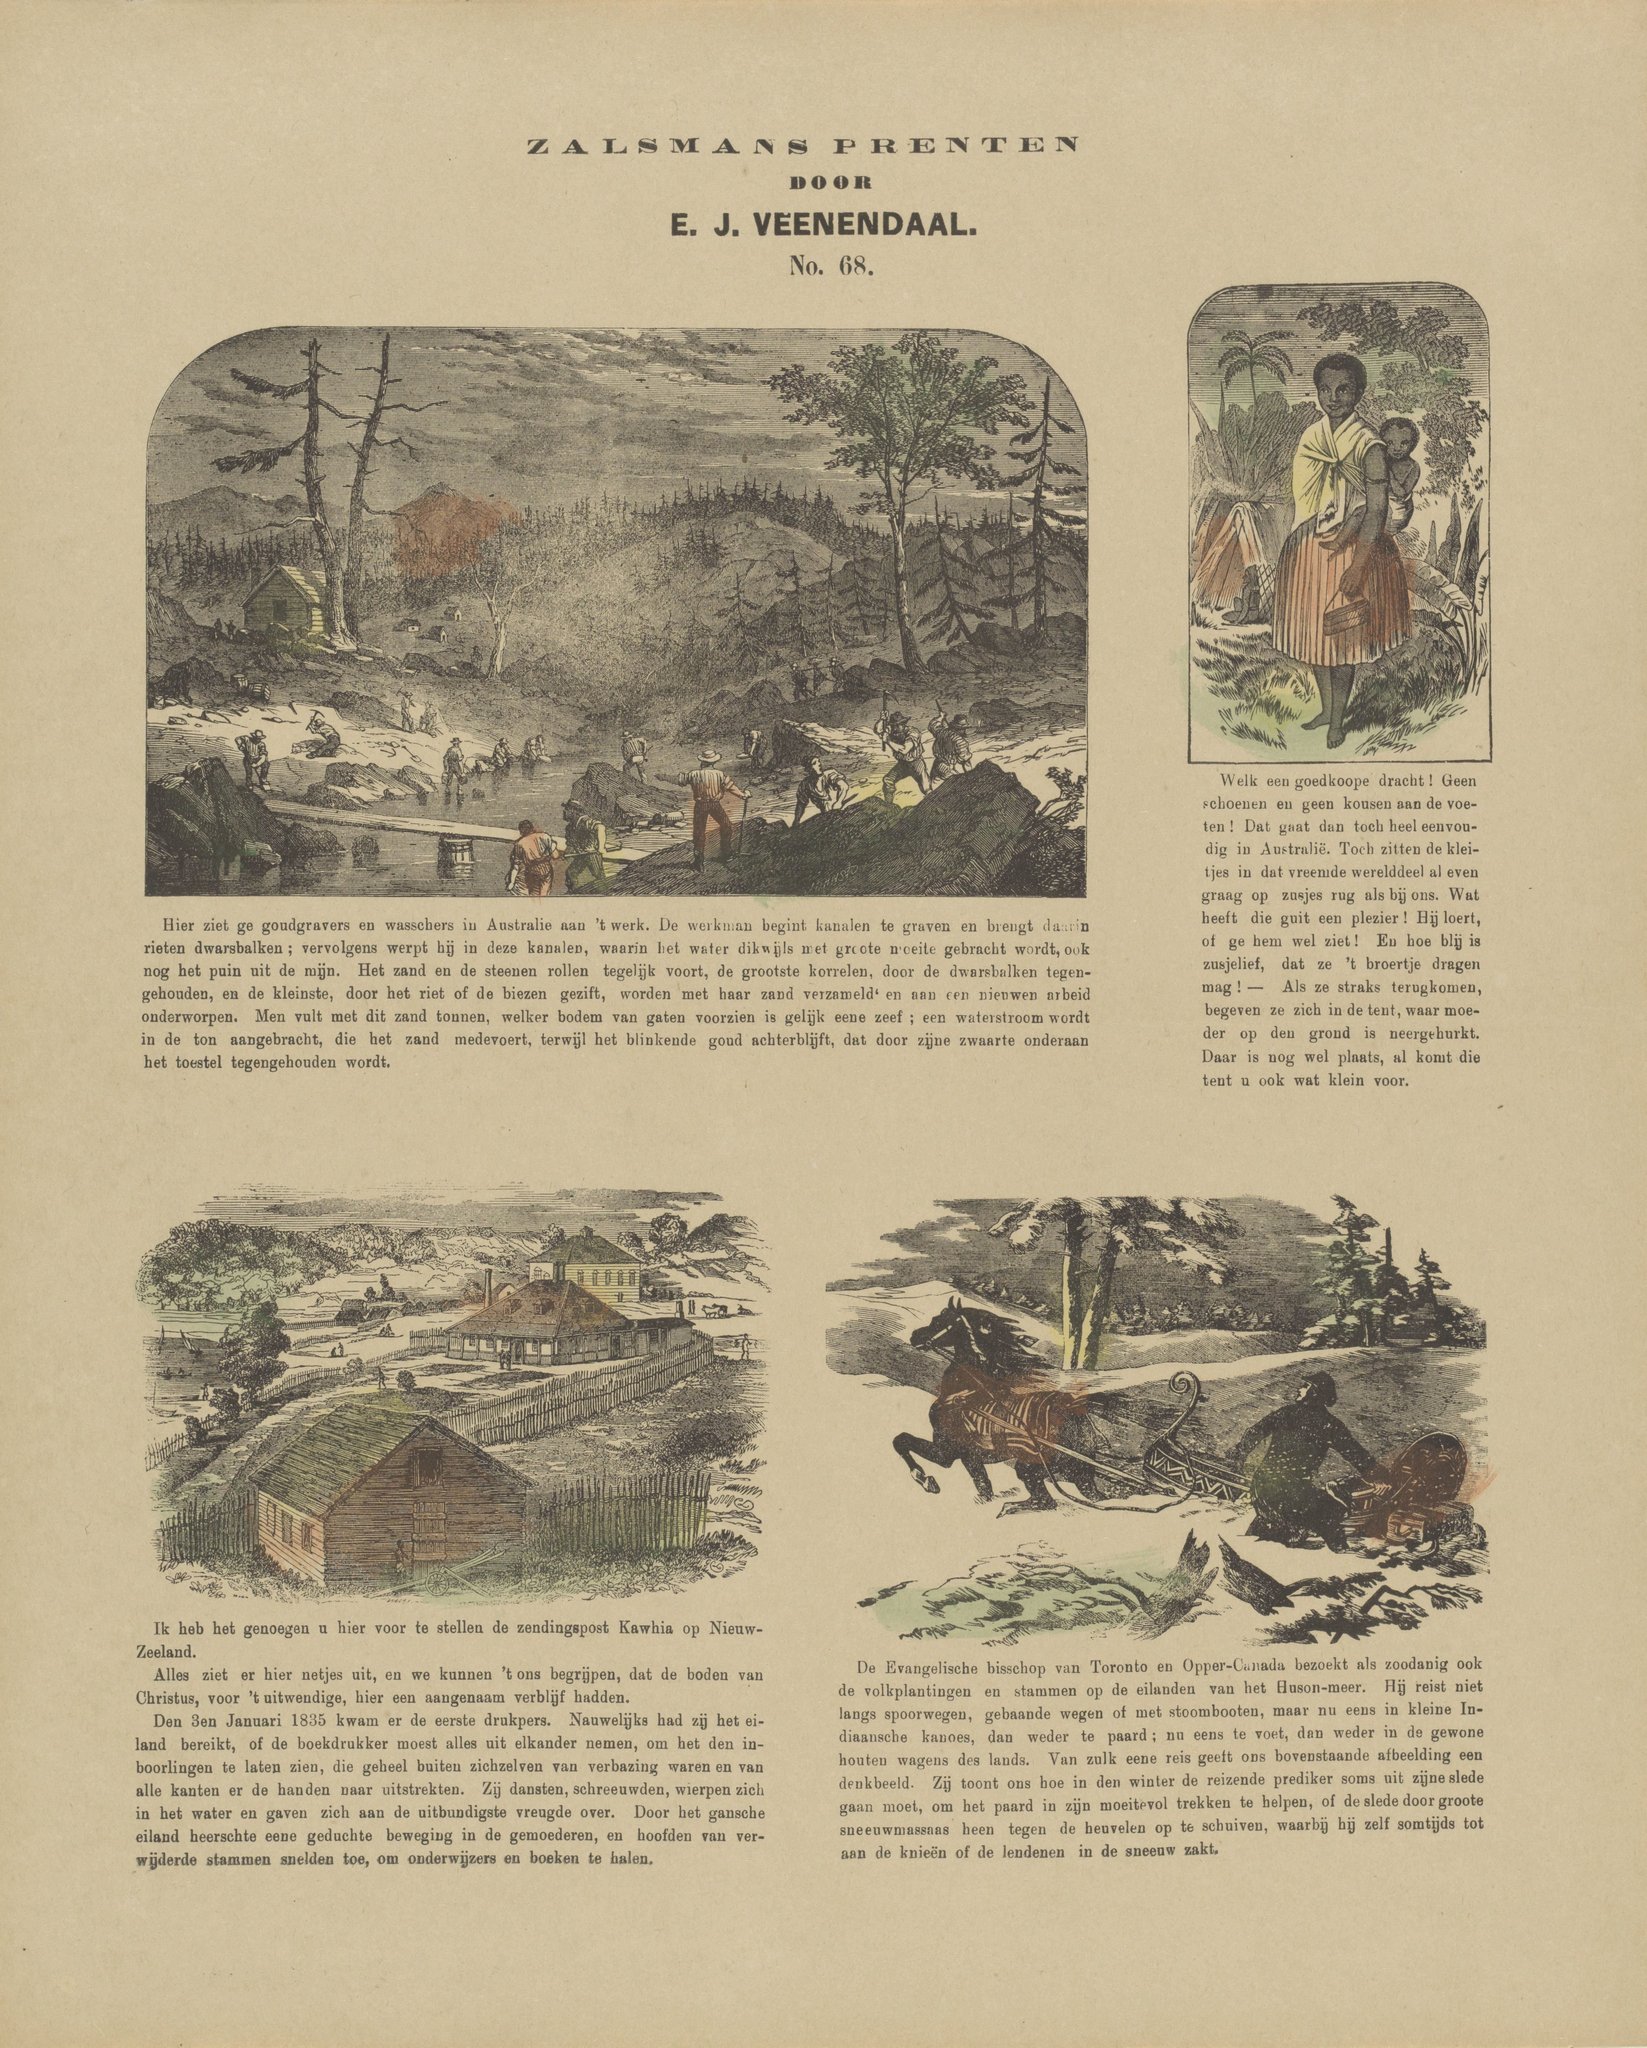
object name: print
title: Goudzoekers in Australië, een Australisch meisje met haar broertje, een zendingspost op Nieuw-Zeeland en een bisschop op een slee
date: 1869-1882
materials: paper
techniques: colour, letterpress printing, engraving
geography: europe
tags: horse-sleigh, prospector, spreading the gospel; missionary work, australia, new zealand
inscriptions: collector's mark: Lugt 2760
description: Blad met 4 voorstellingen van goudzoekers in Australië, een Australisch meisje met haar broertje, een zendingspost op Nieuw-Zeeland en een bisschop op een slee. Onder elke afbeelding een onderschrift. Genummerd midden boven: No. 68.